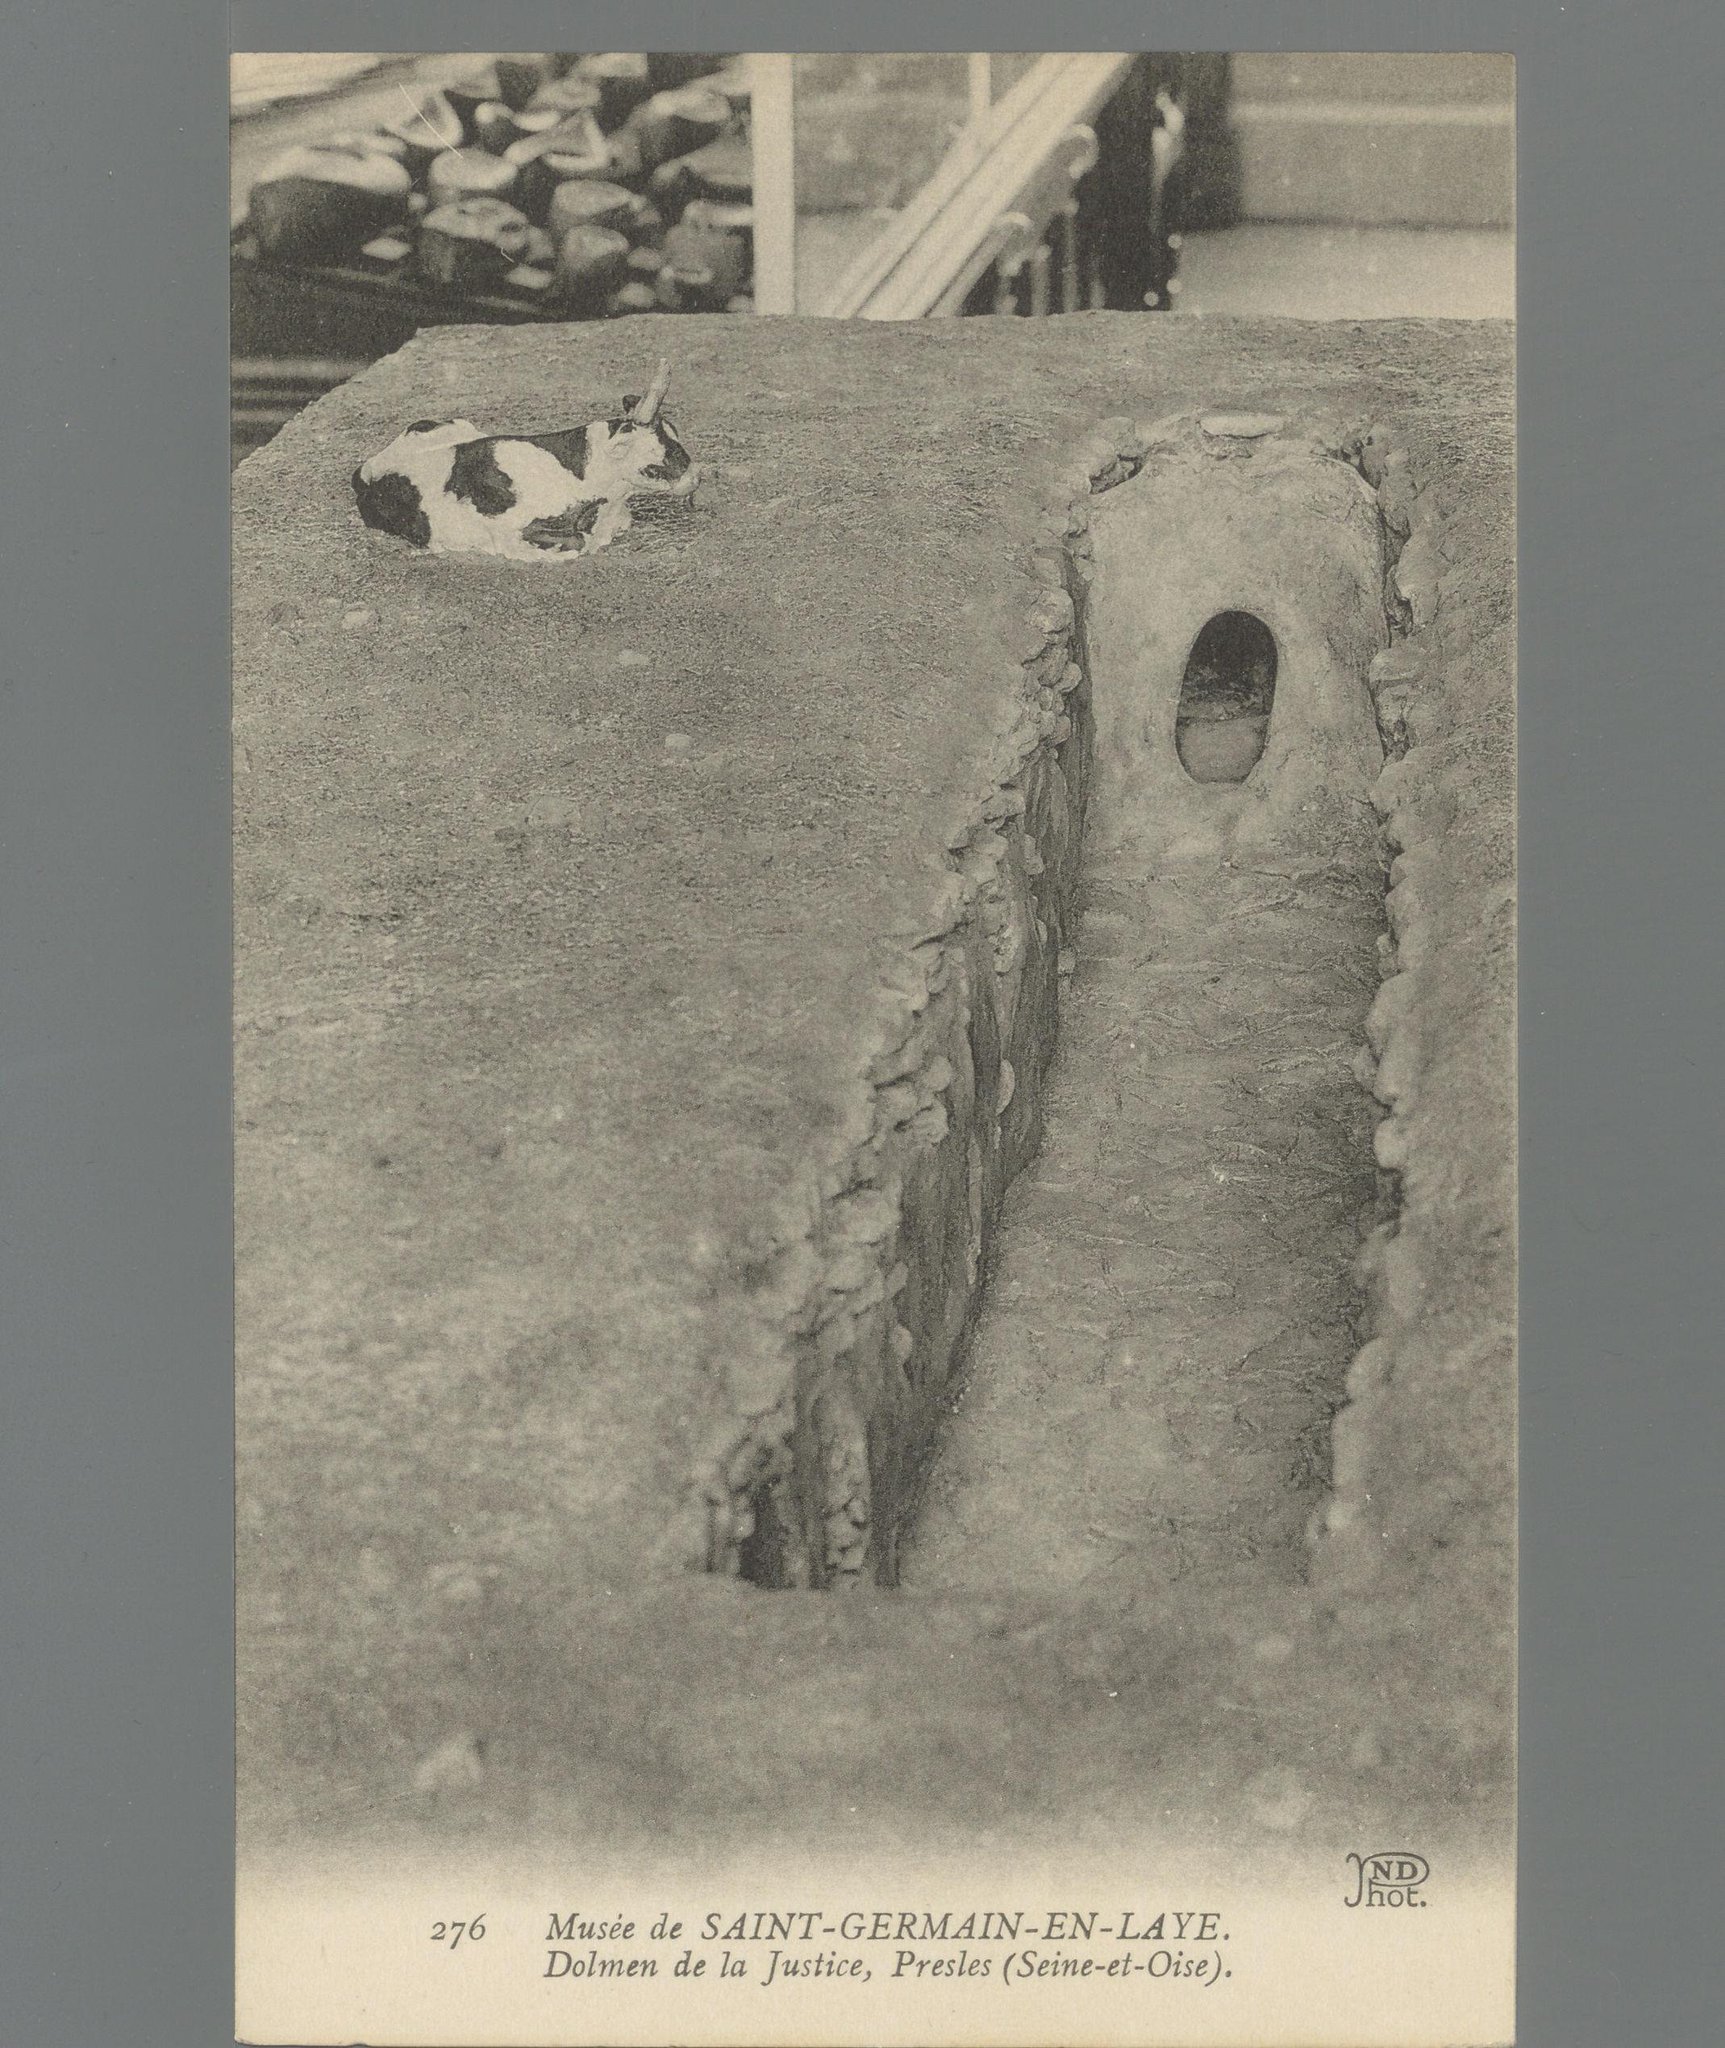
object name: photomechanical print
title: Dolmen de la Justice, Presles (Seine-et-Oise)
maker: Anonymous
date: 1903-1918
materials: cardboard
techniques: photograph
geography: saint-germain-en-laye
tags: permanent exhibition, museum, megalithic chambered tomb, dolmen